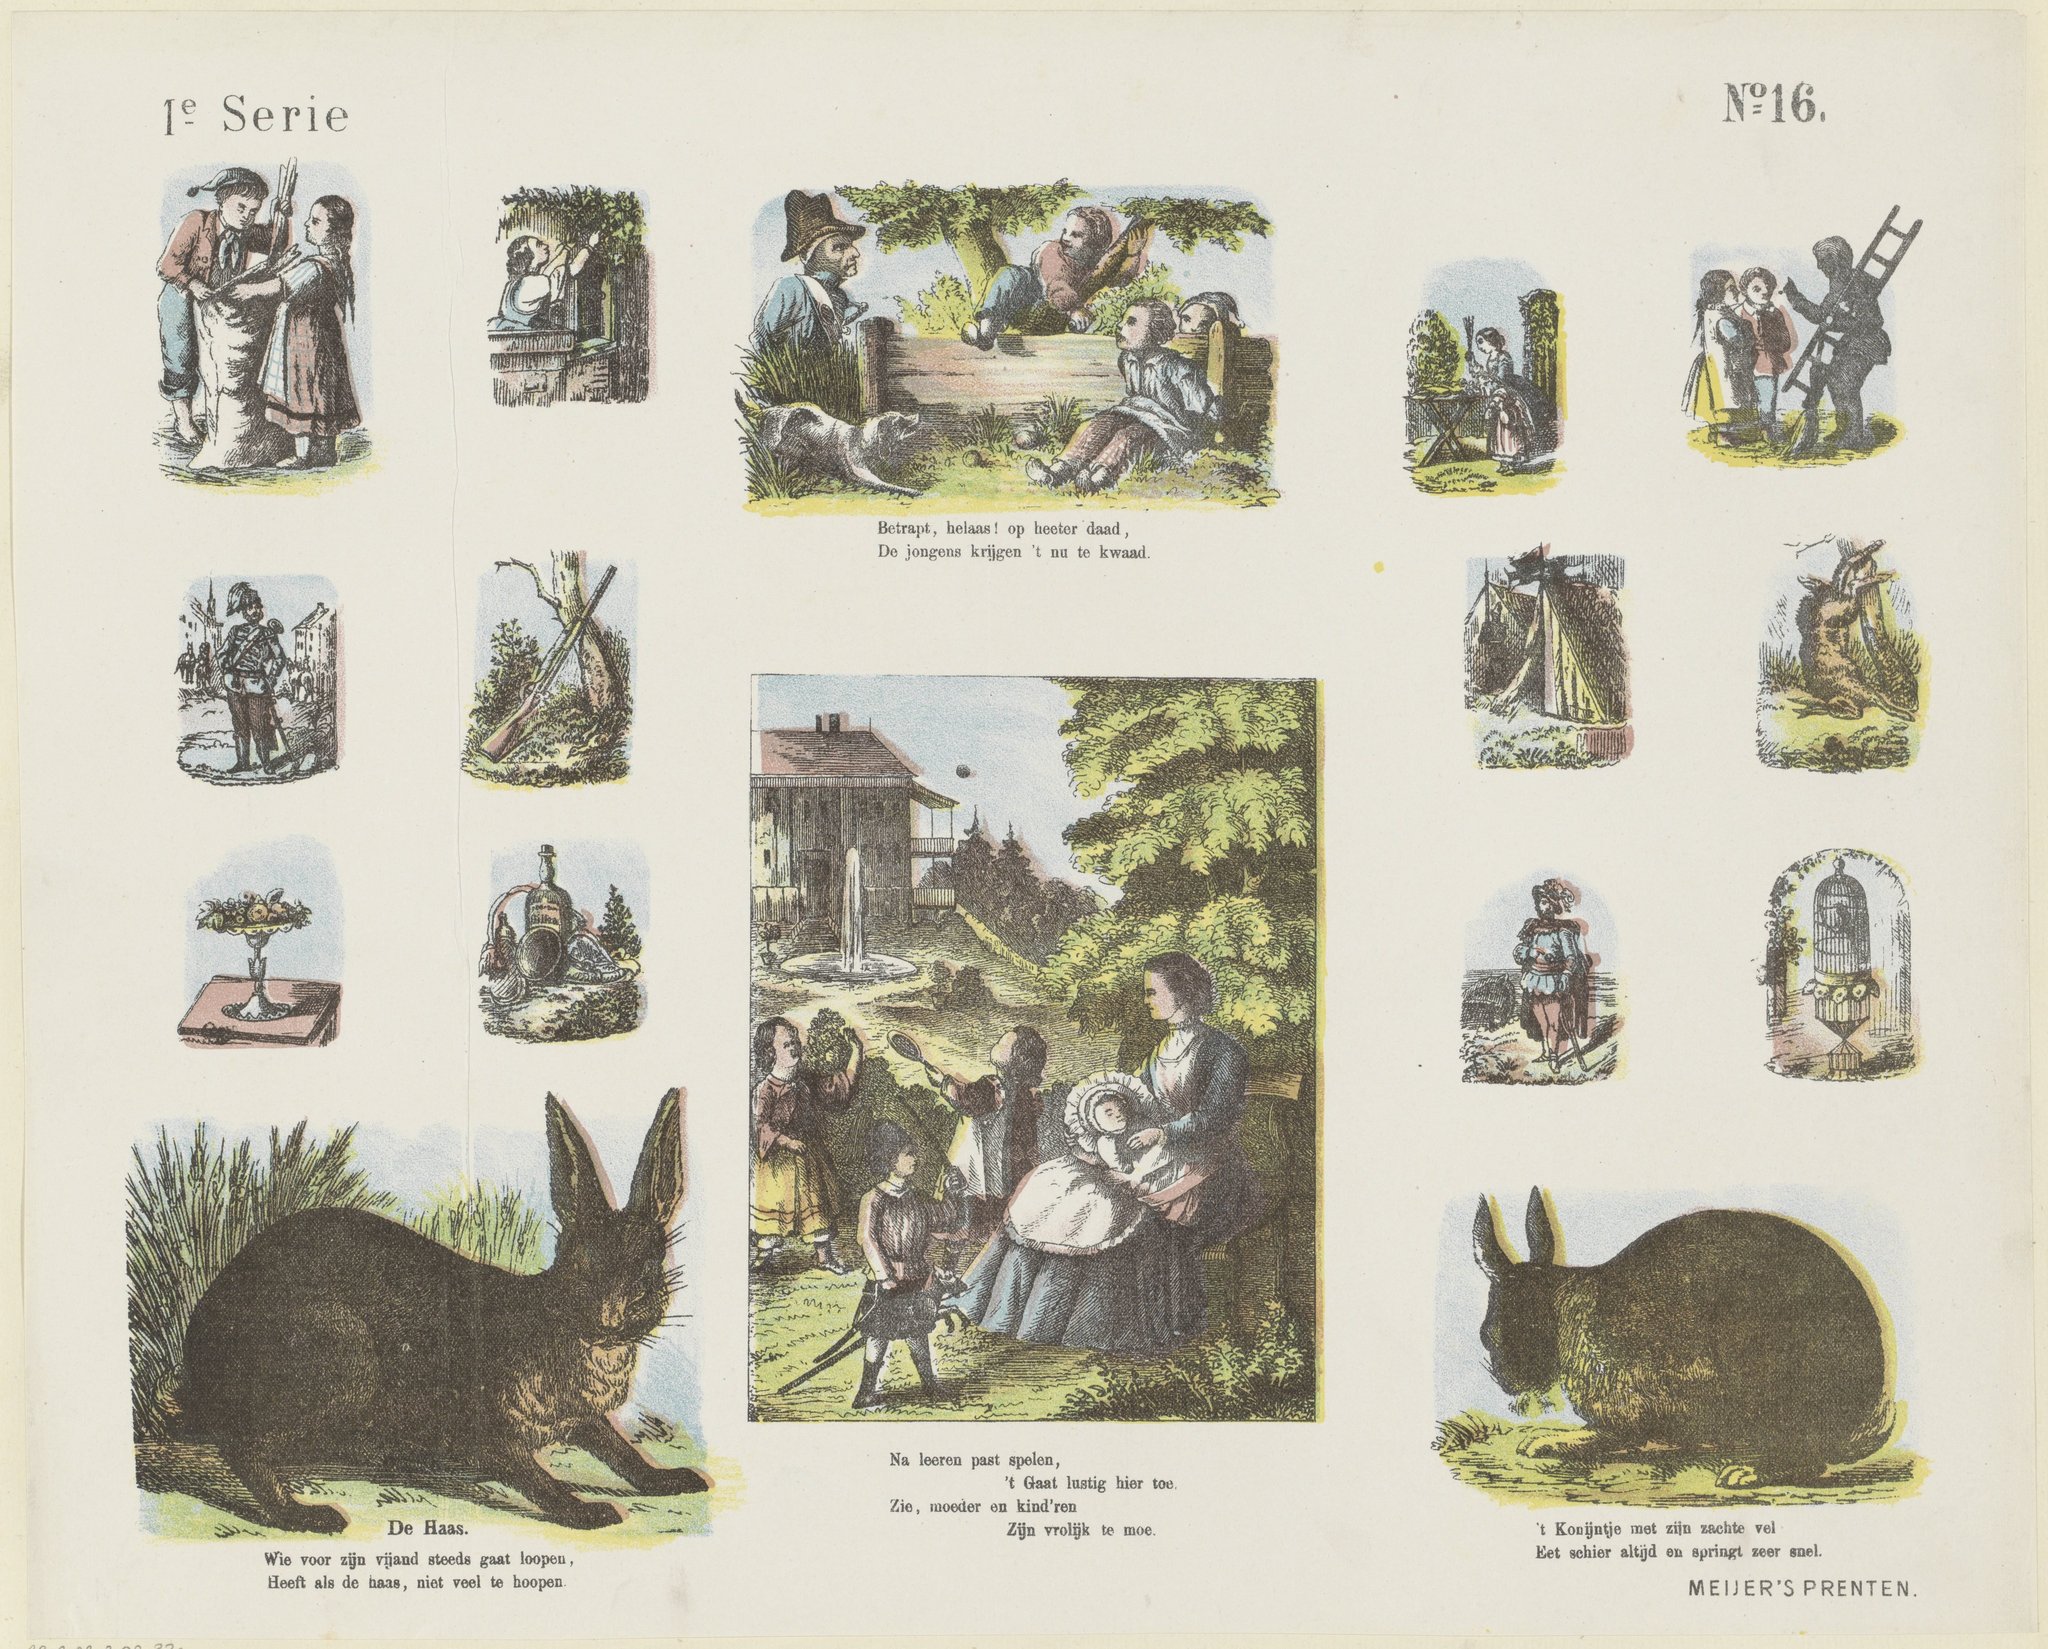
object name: print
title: Meijer's prenten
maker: Anonymous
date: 1873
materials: paper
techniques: lithograph, letterpress printing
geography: amsterdam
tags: animals, birds, handicrafts ~ maintenance and repair (with name of trade or profession), the soldier; the soldier's life, fruits: cherry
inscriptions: collector's mark: Lugt 2760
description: Blad met 16 voorstellingen van verschillende aard, waaronder dieren, kinderen die hout sprokkelen, soldaten en een schoorsteenveger. Onder enkele afbeeldingen een onderschrift. Genummerd rechtsboven: No. 16.